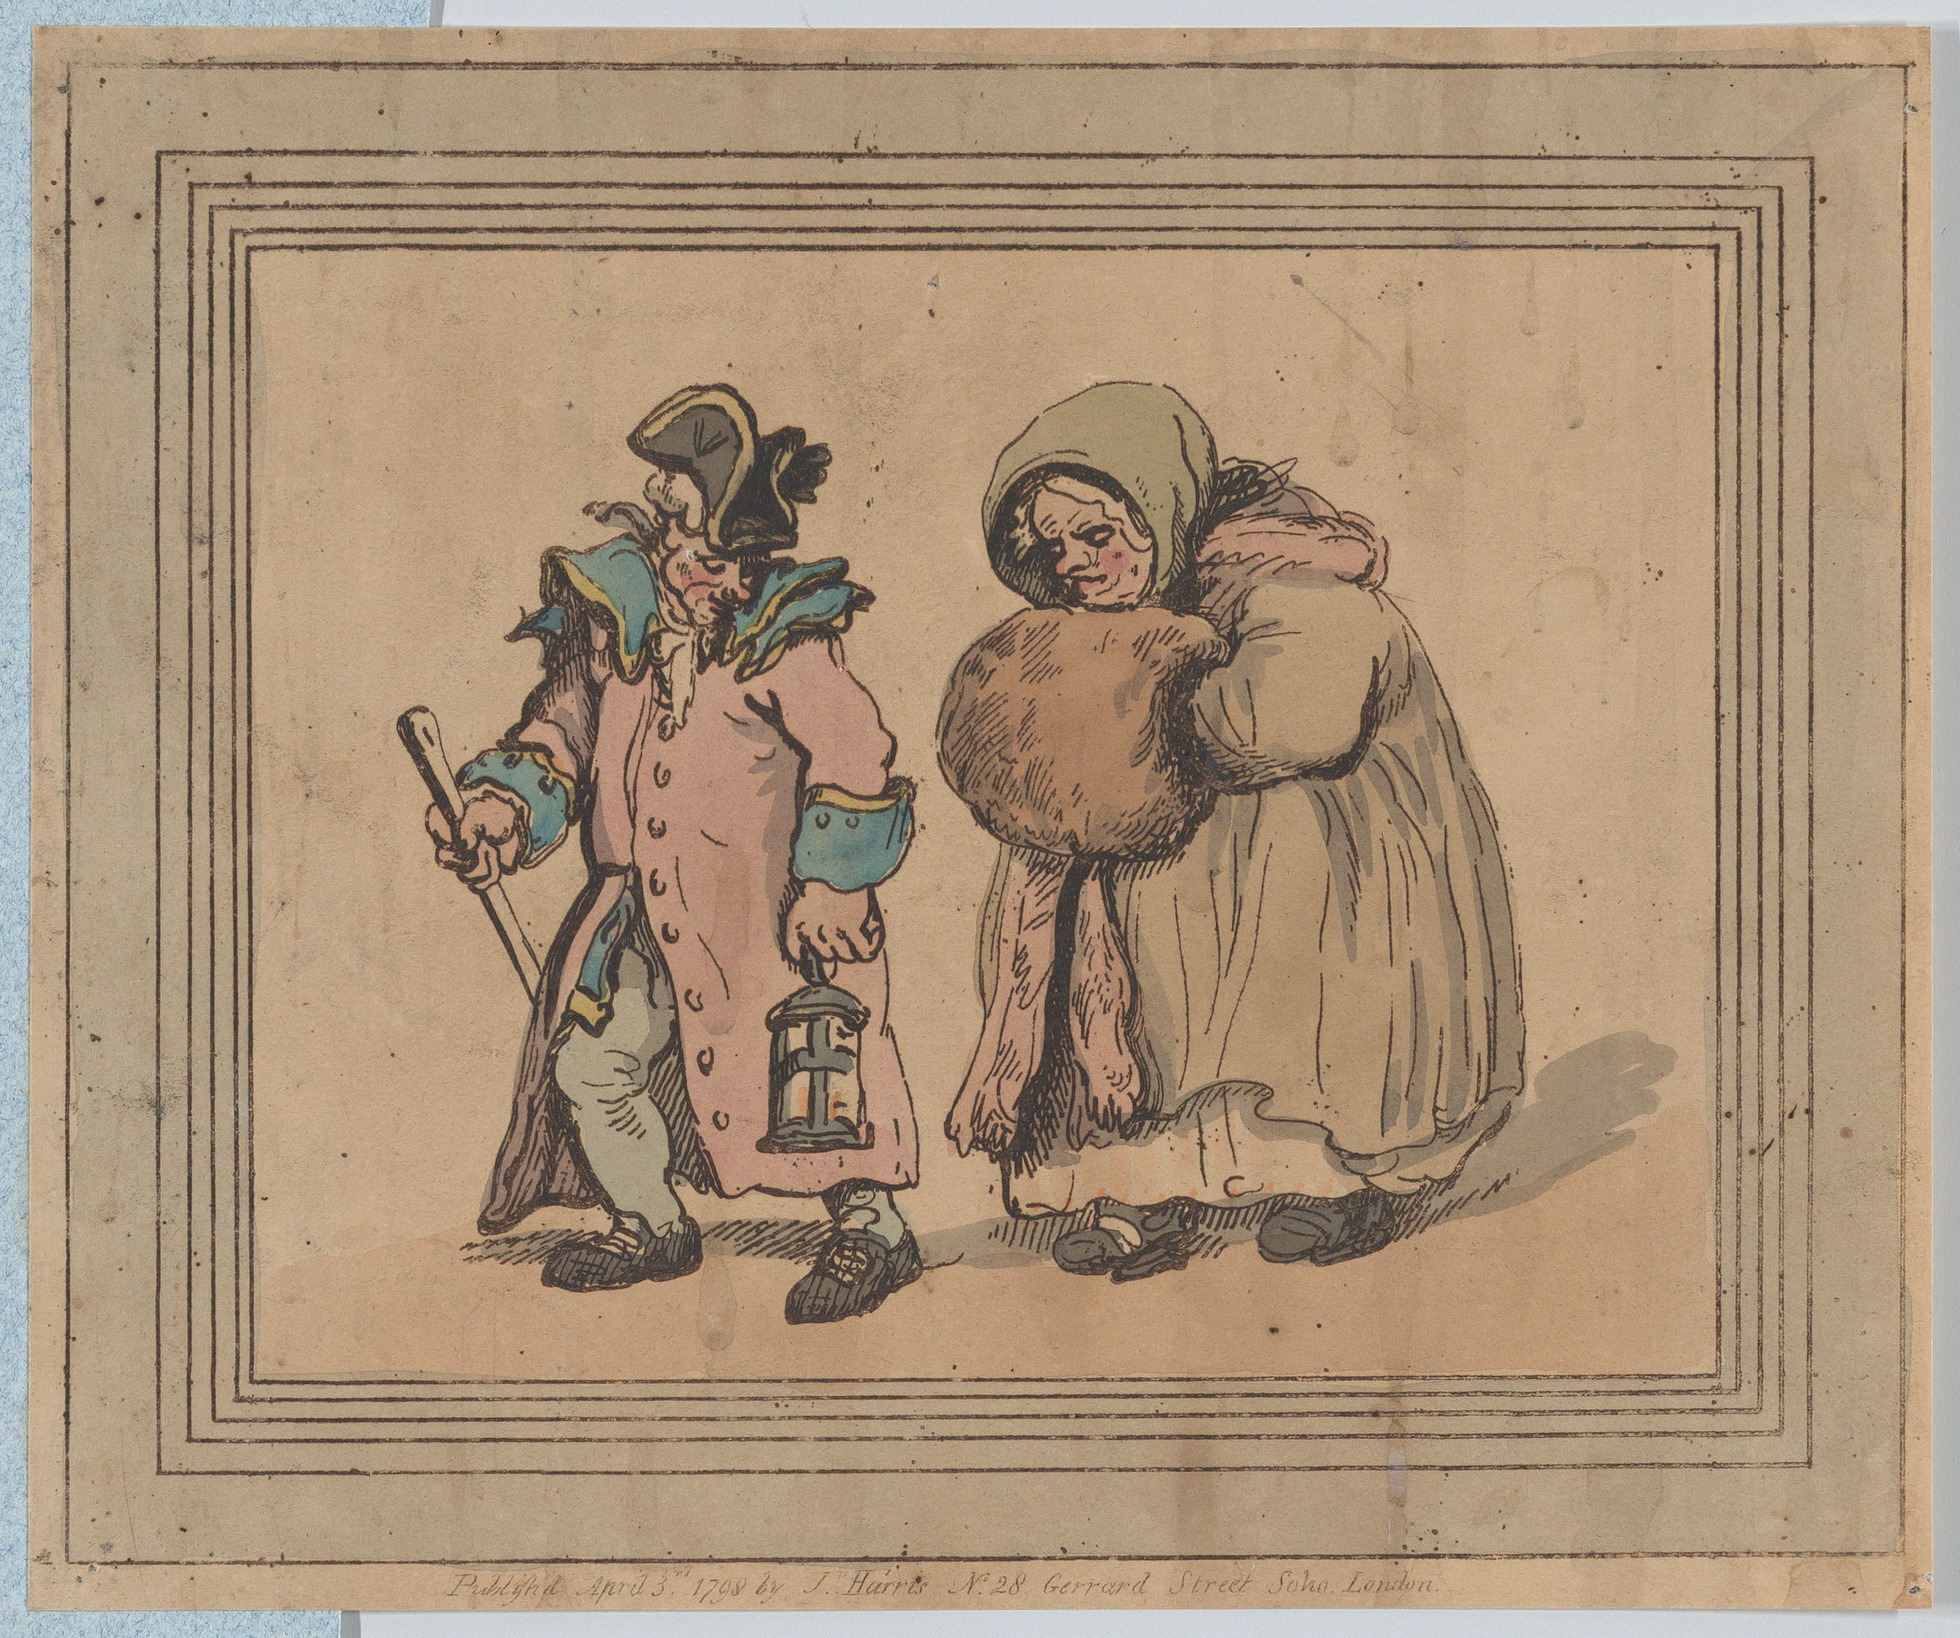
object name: print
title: A Return from a Visit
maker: thomas rowlandson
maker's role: artist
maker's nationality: british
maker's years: 1757-1827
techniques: etching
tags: men,women,caricature